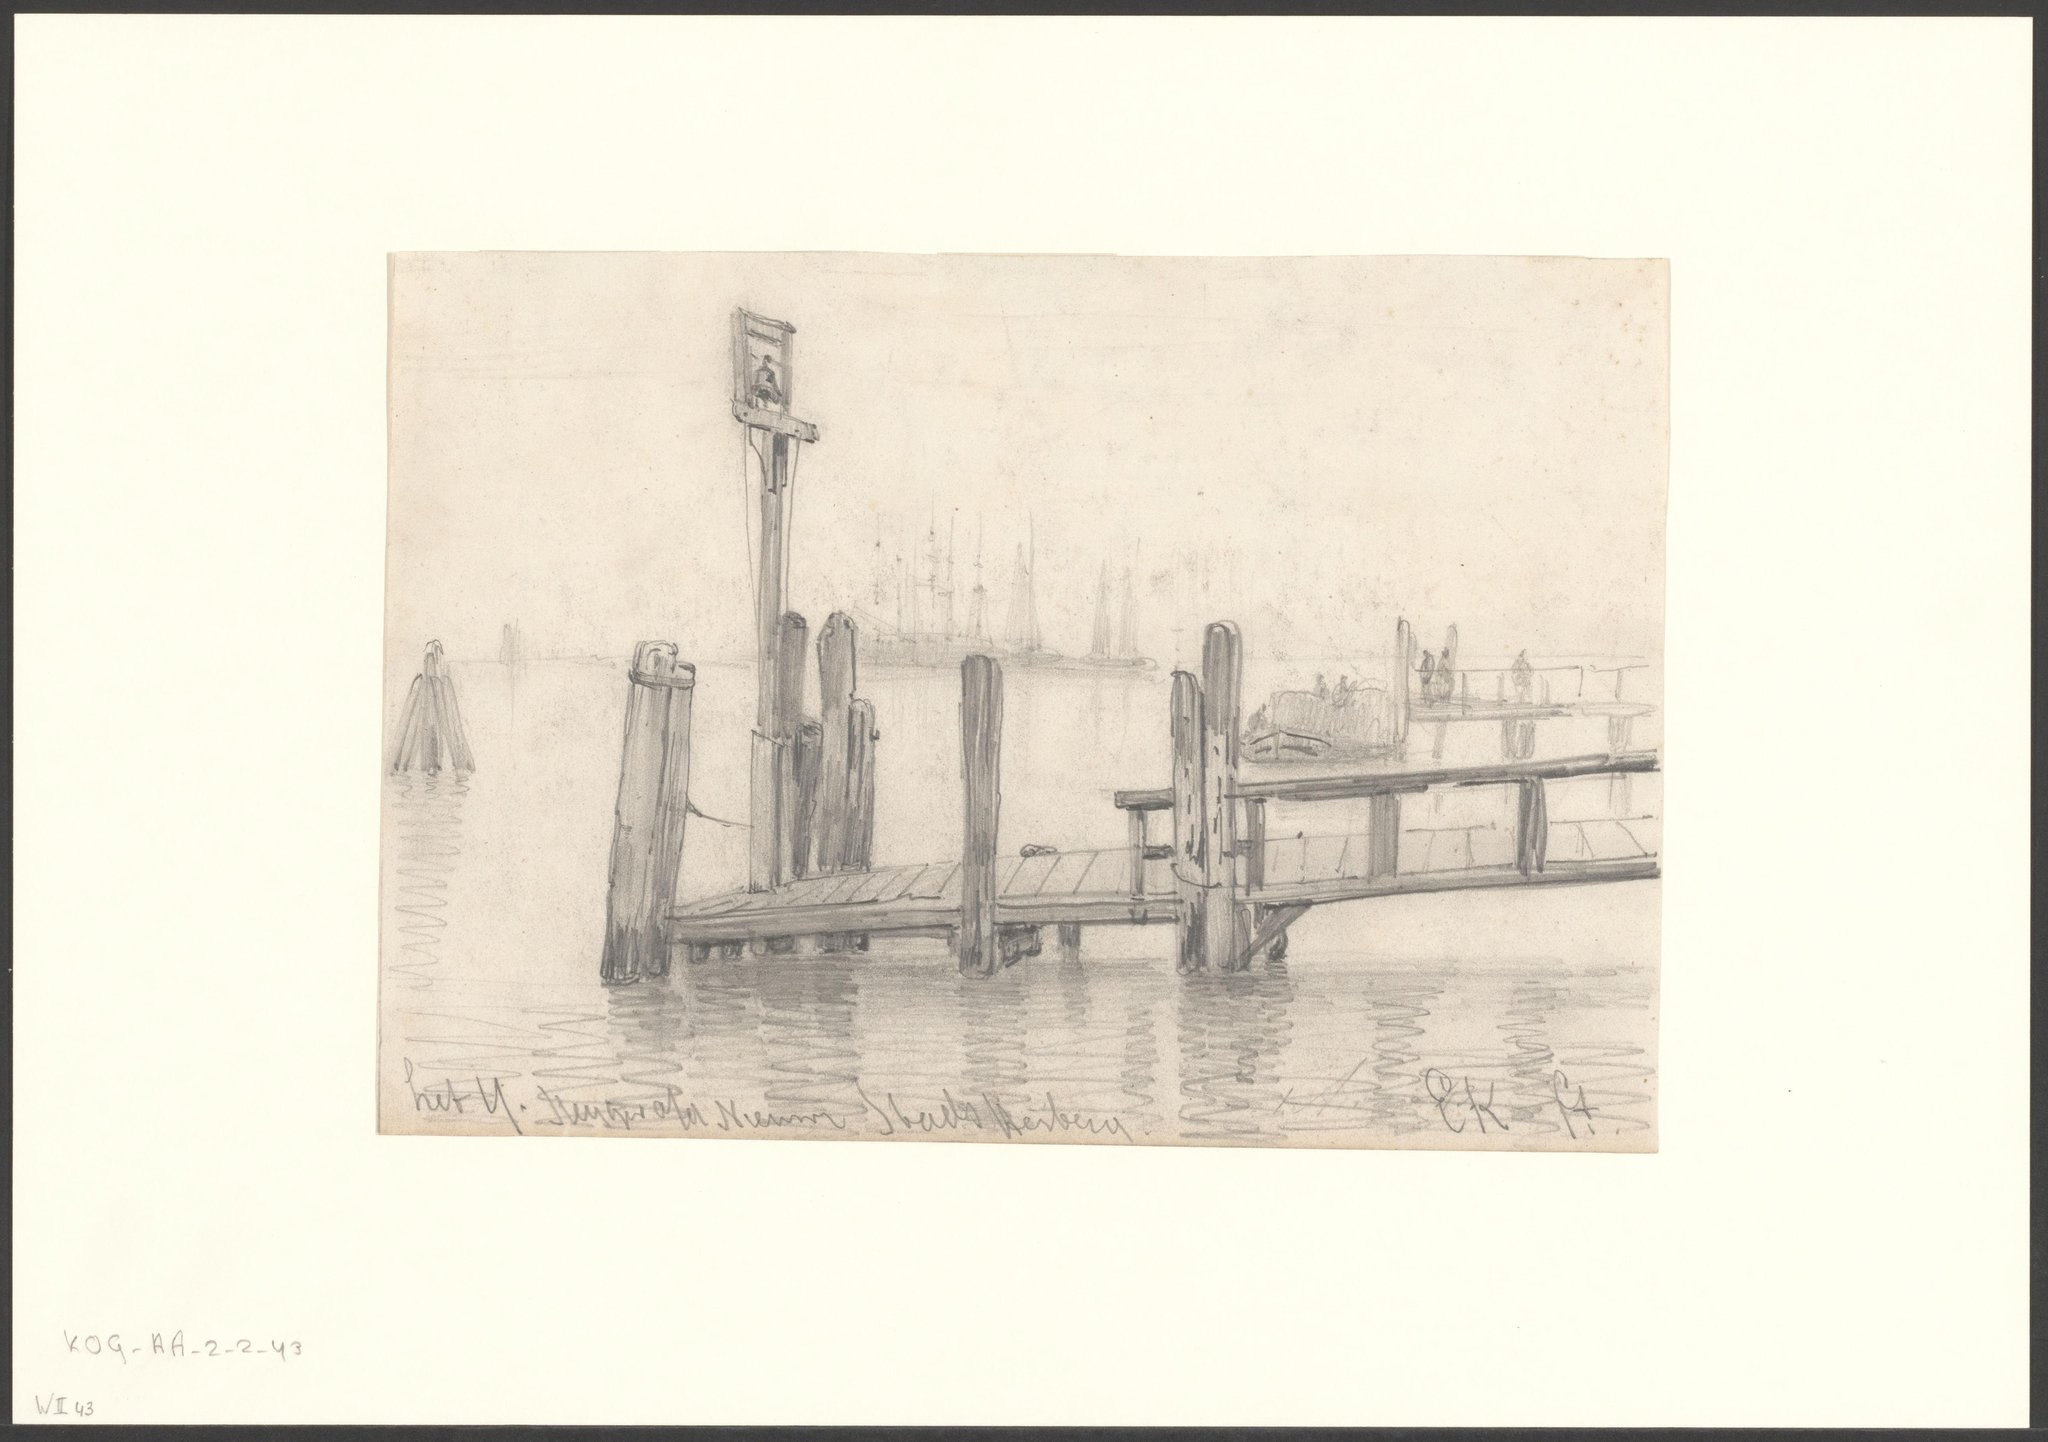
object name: drawing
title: Gezicht op de steiger bij de Nieuwe Stadsherberg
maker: everhardus koster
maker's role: draughtsman, painter, print maker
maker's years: 1817-1892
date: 1827-1892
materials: paper, pencil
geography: amsterdam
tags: city-view in general; 'veduta', river, pier, quay, wharf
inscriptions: inscription: ‘het Y. steiger a/d Nieuwe Stads Herberg’, signature: ‘EK ft.’, collector's mark: Lugt 800a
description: Tekening binnen de Atlas Van Eck ingedeeld op wijknummer 2.